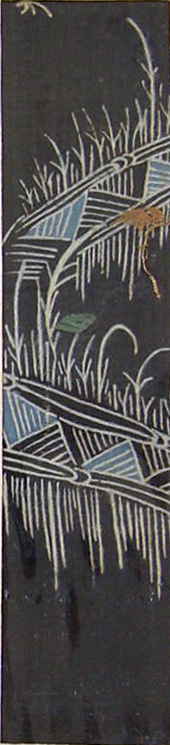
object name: piece from a kosode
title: Piece from a Kosode with Garden Fence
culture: japanese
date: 1615-1868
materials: metal thread, silk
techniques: damask, dyeing, embroidery, painting, resist